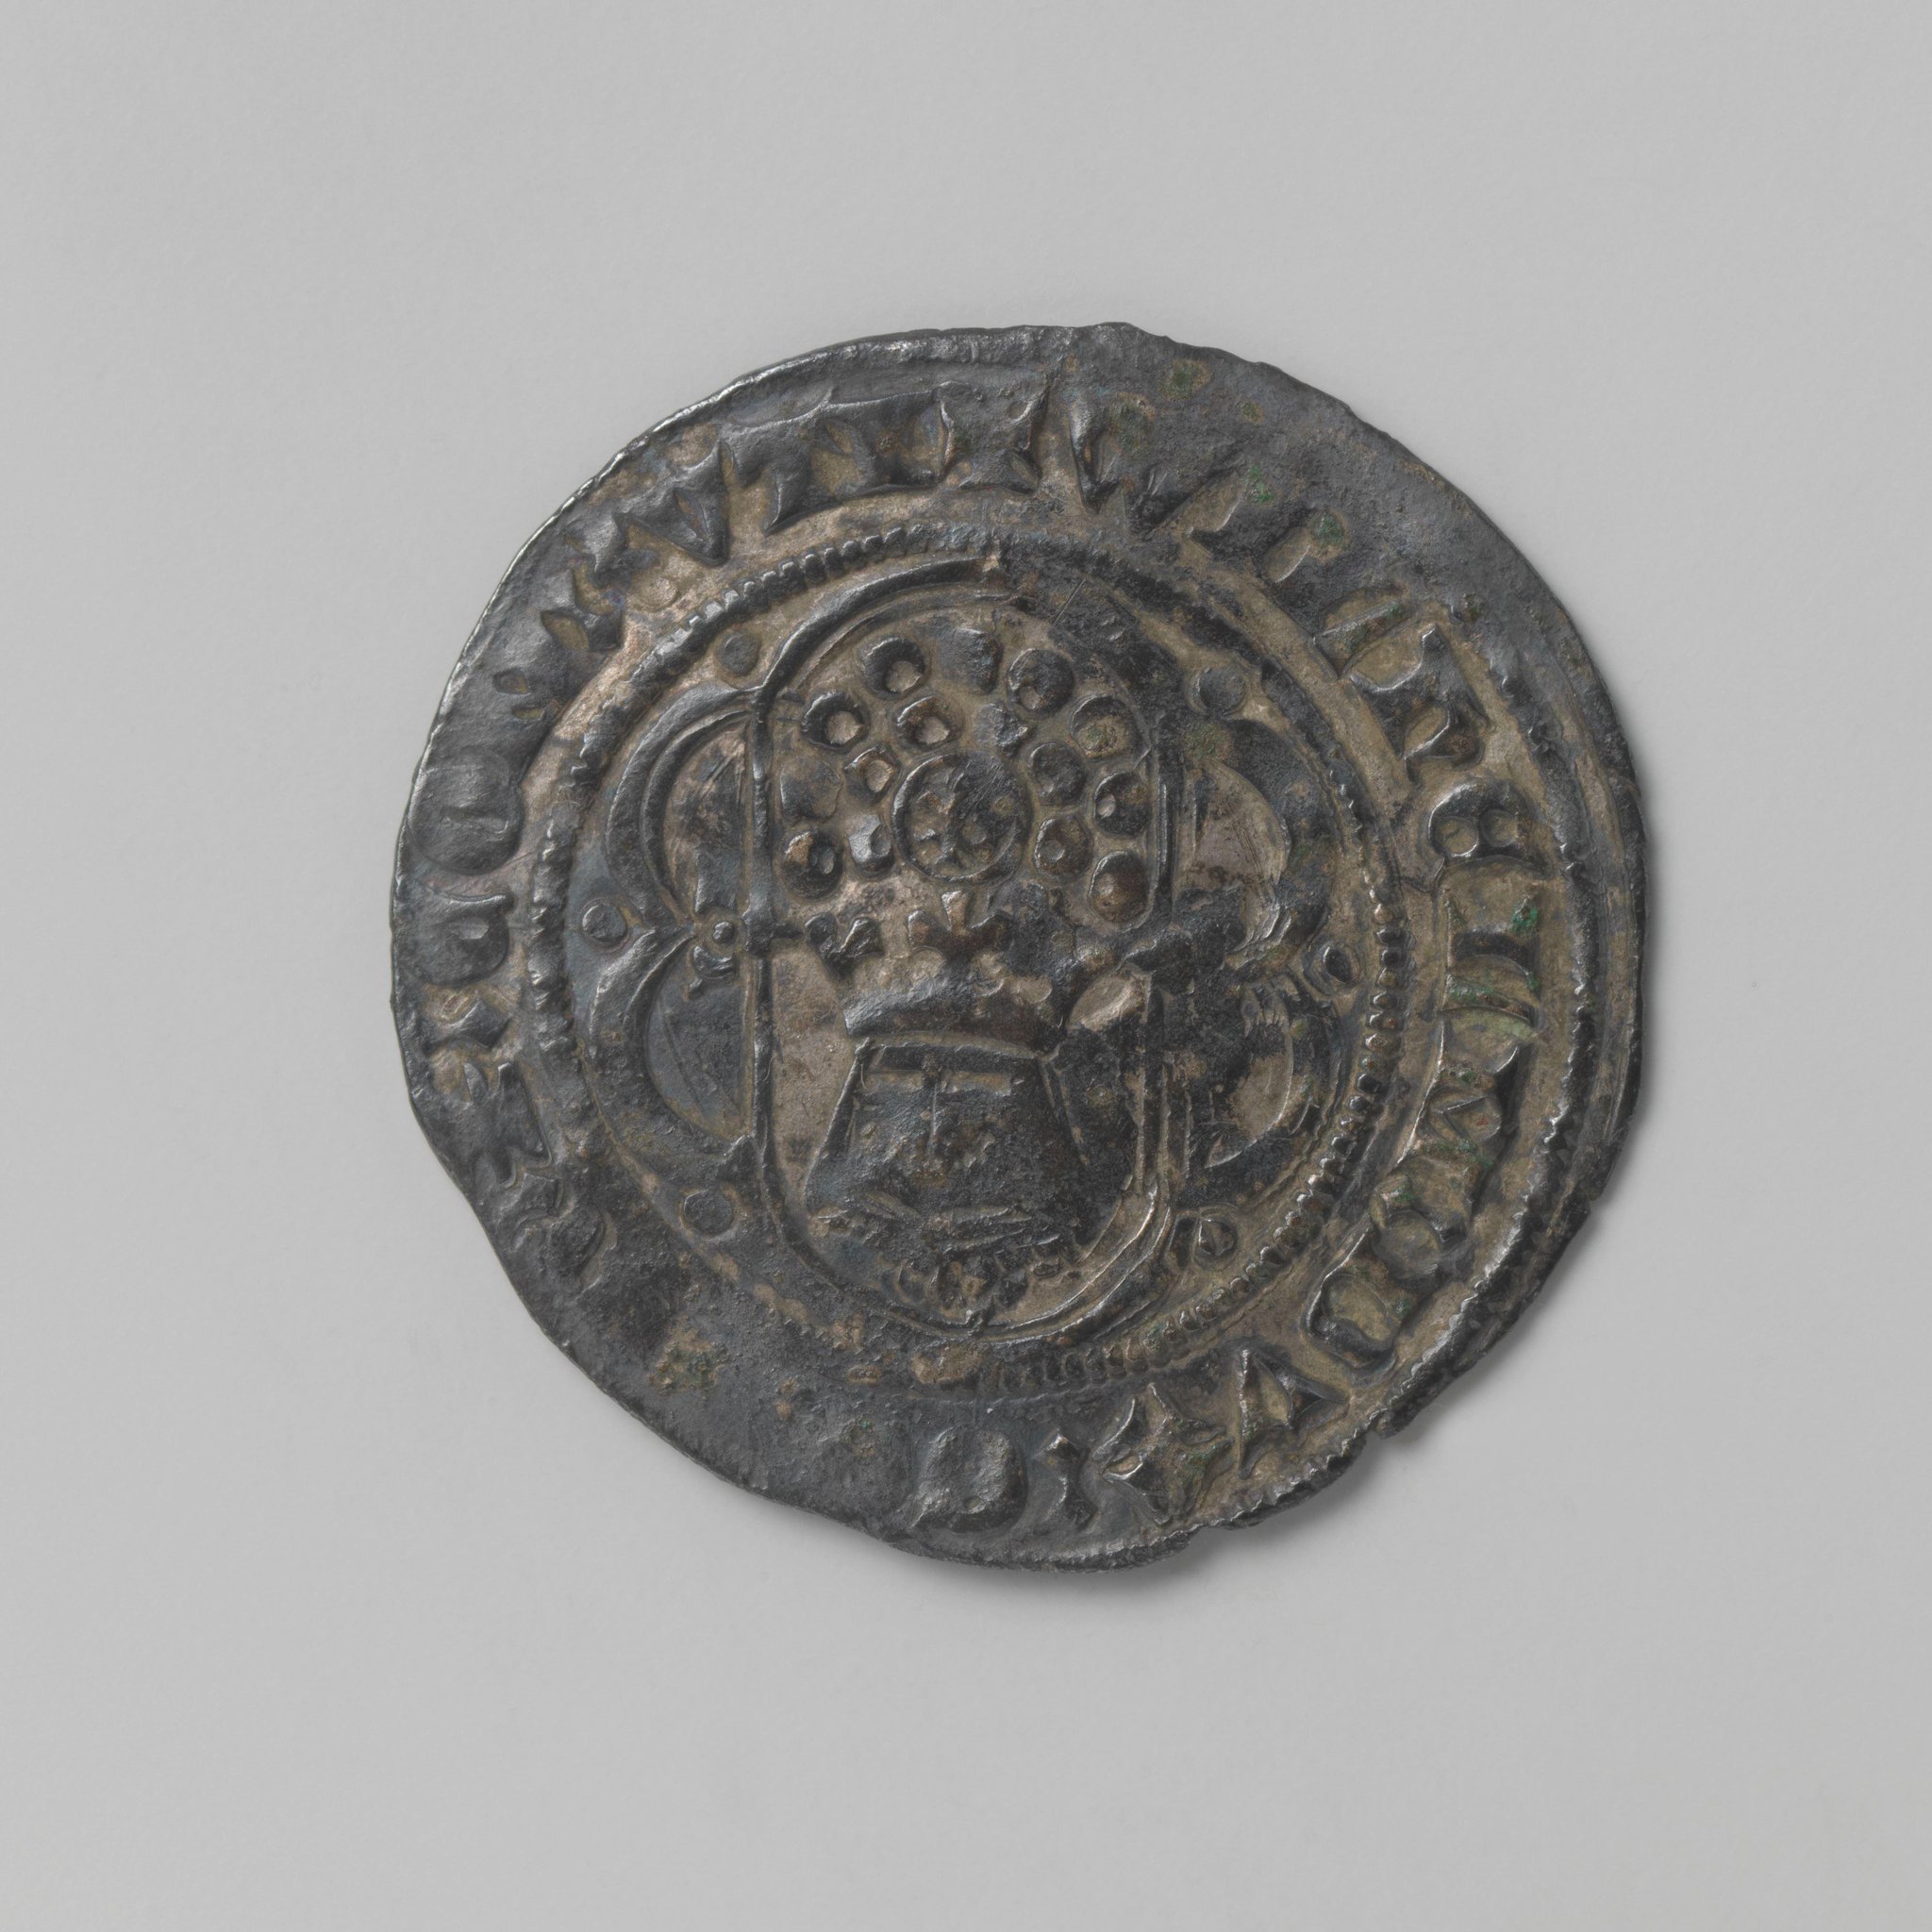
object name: coin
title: Gelderse groot uit Arnhem van hertog Willem I, 1377-1393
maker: willem van gulik (hertog van gelre)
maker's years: 1364-1402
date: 1377-1393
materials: silver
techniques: striking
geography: arnhem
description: Zilveren munt. Voorzijde: toernooihelm binnen zespas. Keerzijde: kort gevoet kruis met letters A,N,R en S.